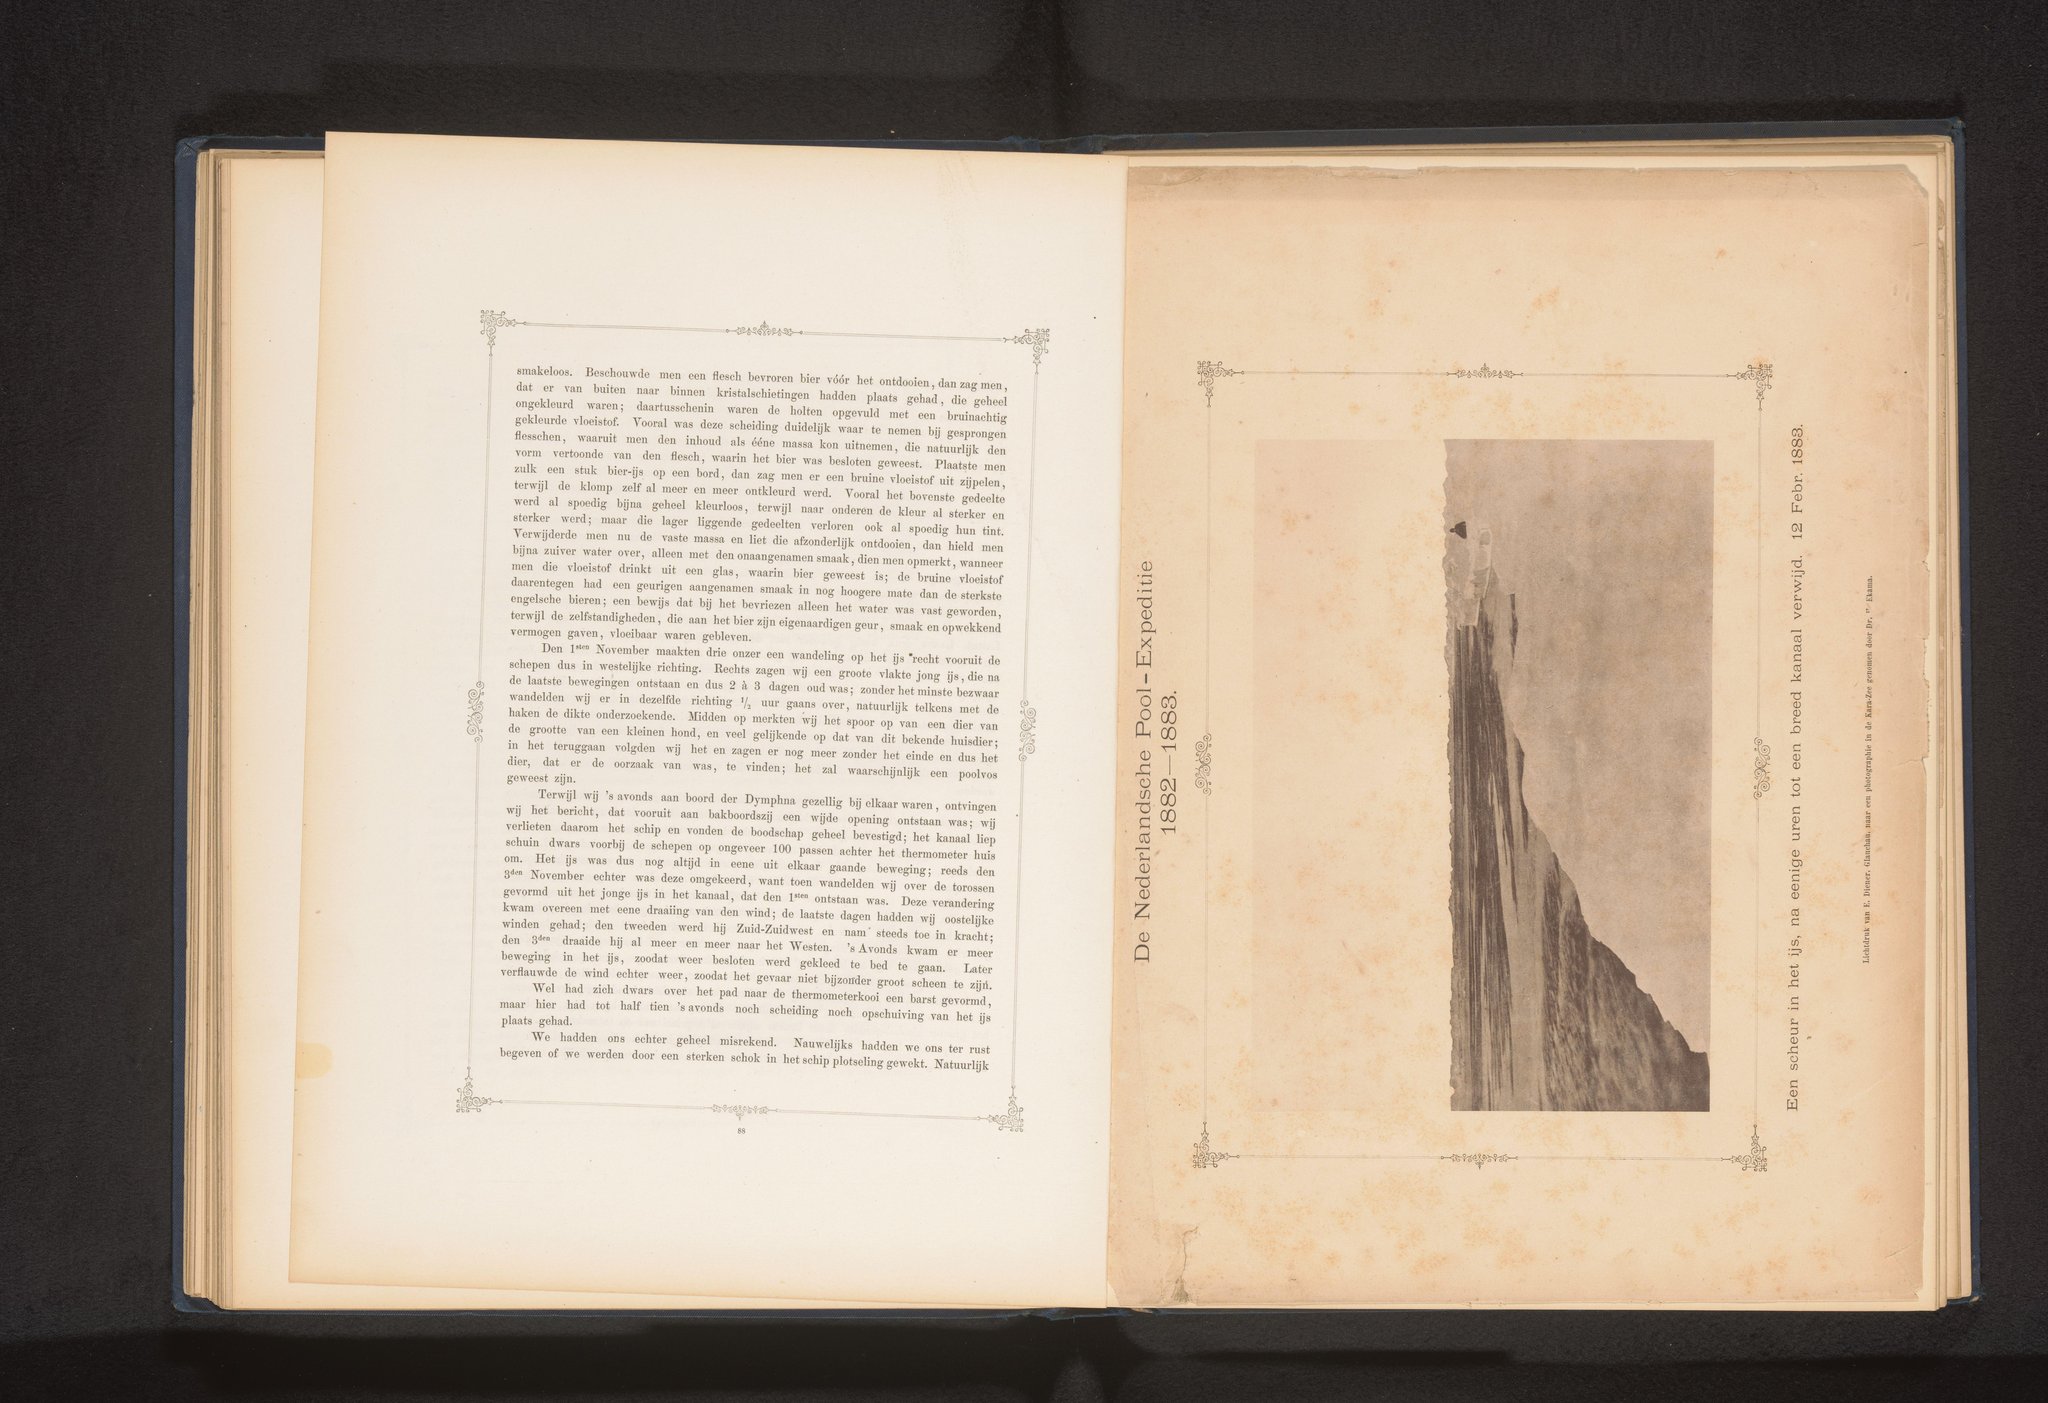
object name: photomechanical print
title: Gezicht op een kanaal tussen de ijsplaten in de Karazee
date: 1881-1886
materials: paper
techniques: photograph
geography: kara sea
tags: icefield, landscapes in polar regions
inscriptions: inscription: ‘De Nederlandsche Pool-Expeditie 1882-1883’